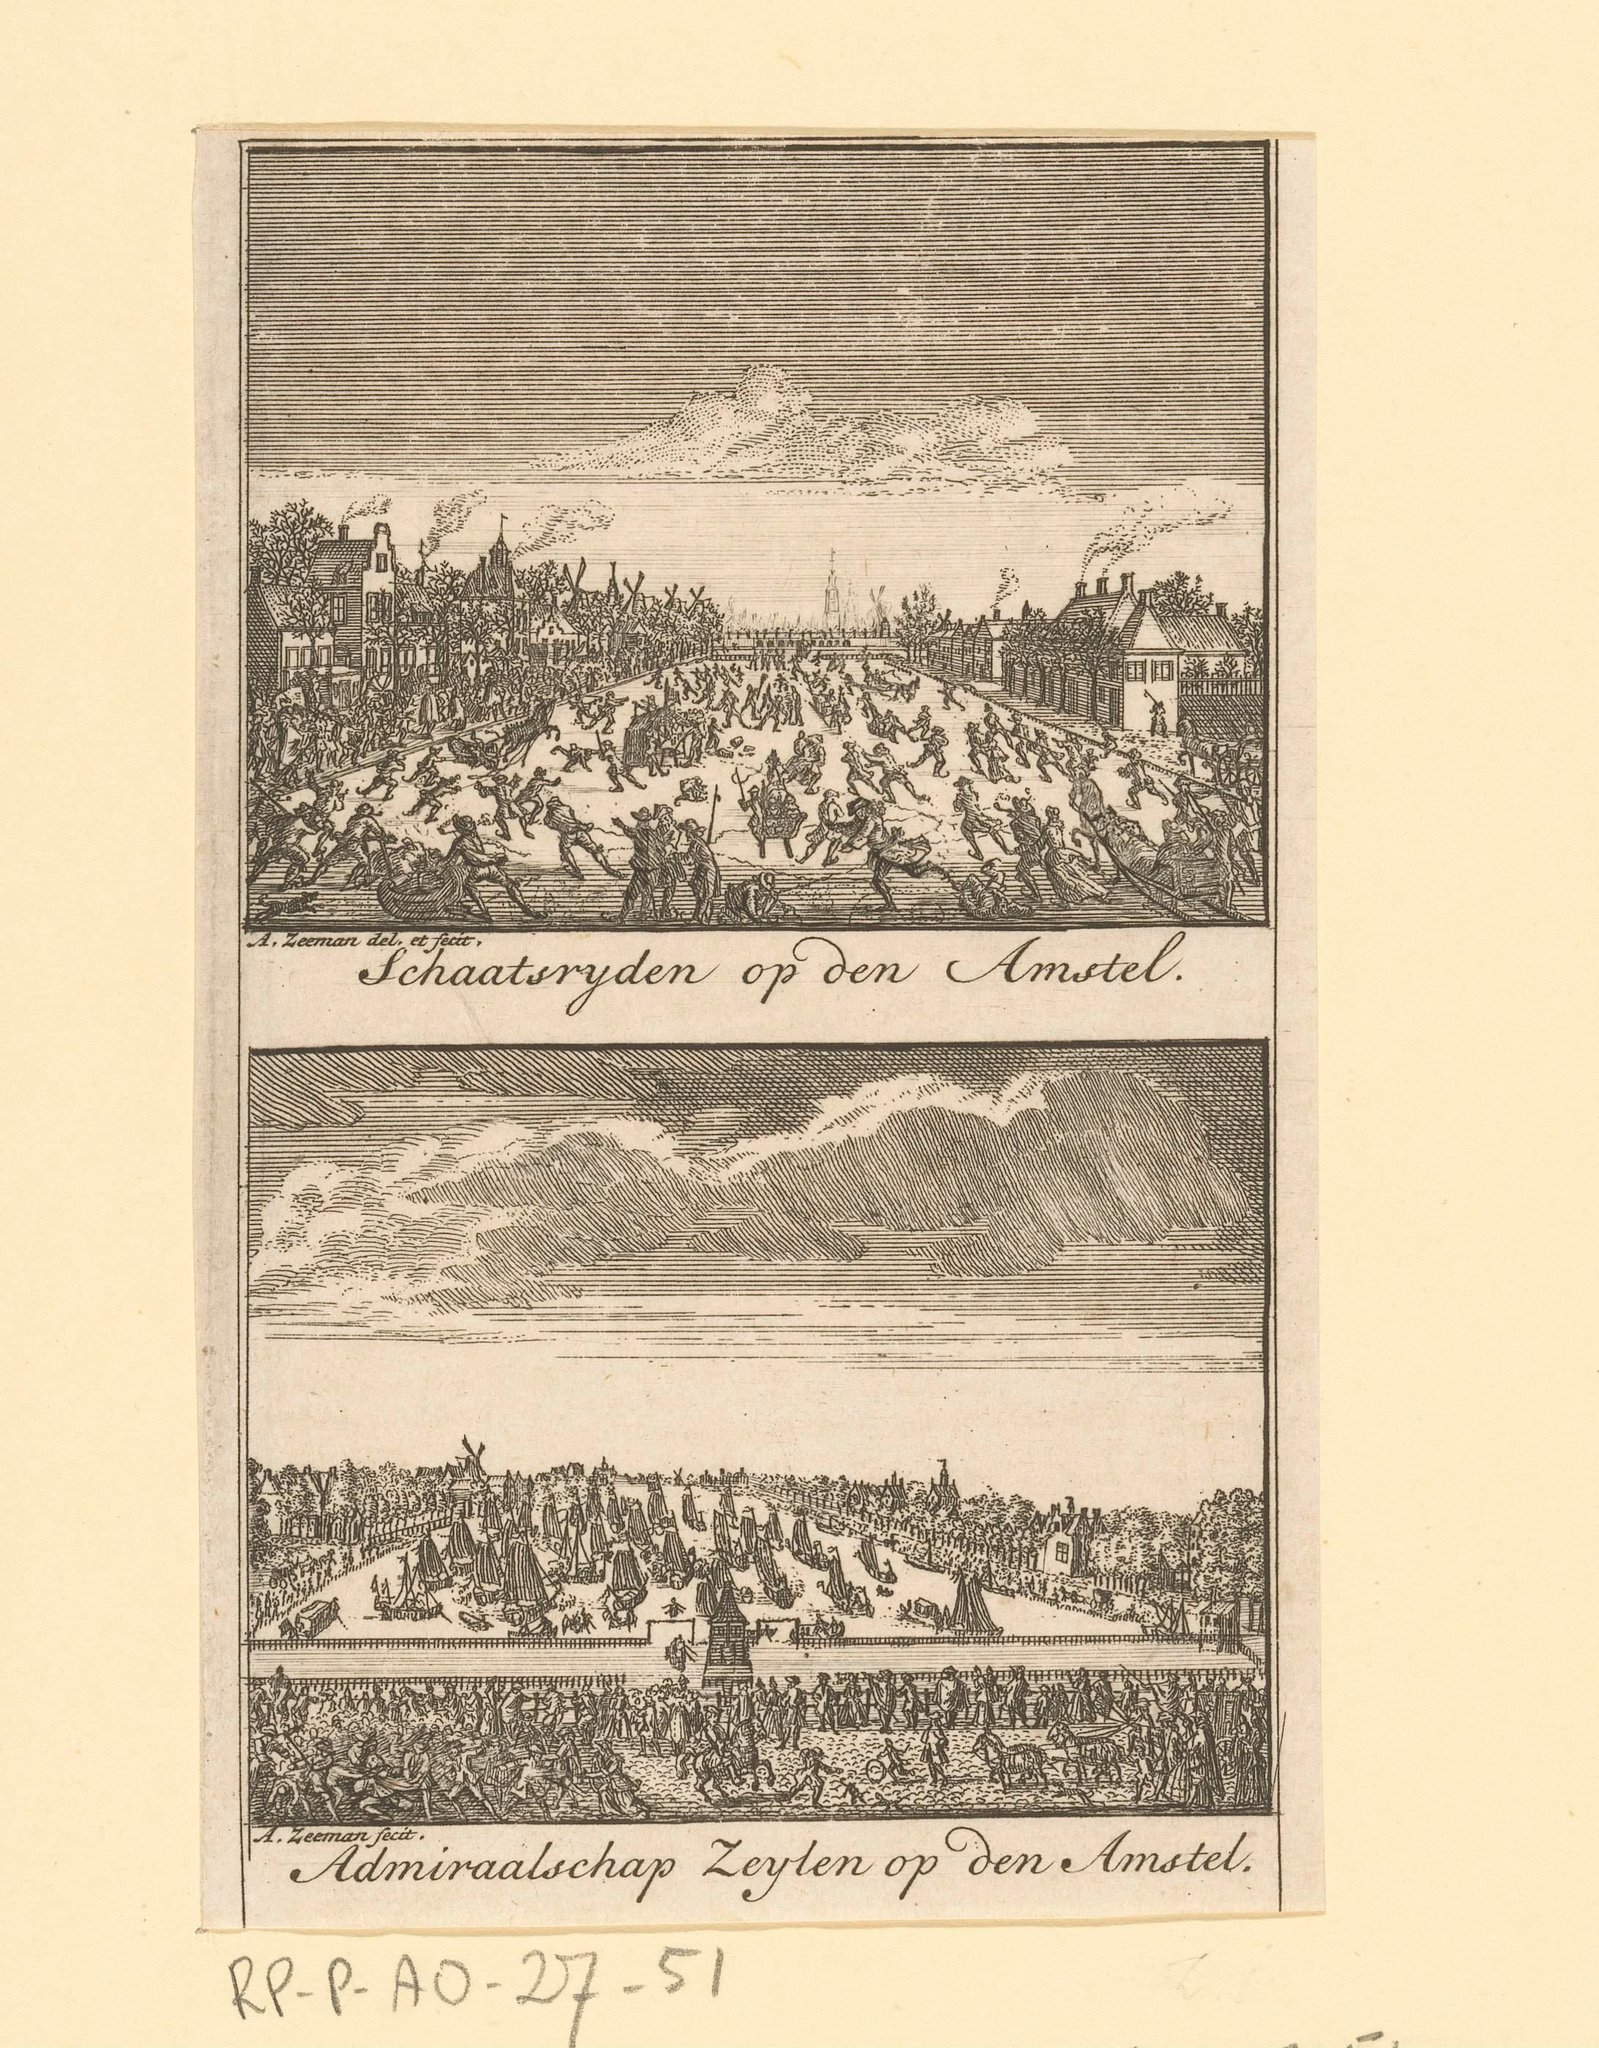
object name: book illustration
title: Schaatsryden op den Amstel / Admiraalschap zeylen op den Amstel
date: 1730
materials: paper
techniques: engraving, etching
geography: amsterdam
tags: bridge in city across river, canal, etc. (+ city(-scape) with figures, staffage), sailing-ship, sailing-boat, sailing (sport), winter sports, skates (winter sports), canals, waters (in city) (+ city(-scape) with figures, staffage)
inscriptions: collector's mark: Lugt 2228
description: Prent ook gebruikt in: Bruin, Claas en Ludolph Smids. Kleefsche en Zuid-Hollandsche arkadia, of Dag-verhaal van twee reizen (…). Vermeerdert met printverbeeldingen. 2e druk. Amsterdam: Evert Visscher, 1730, tussen p. 124 en 125.